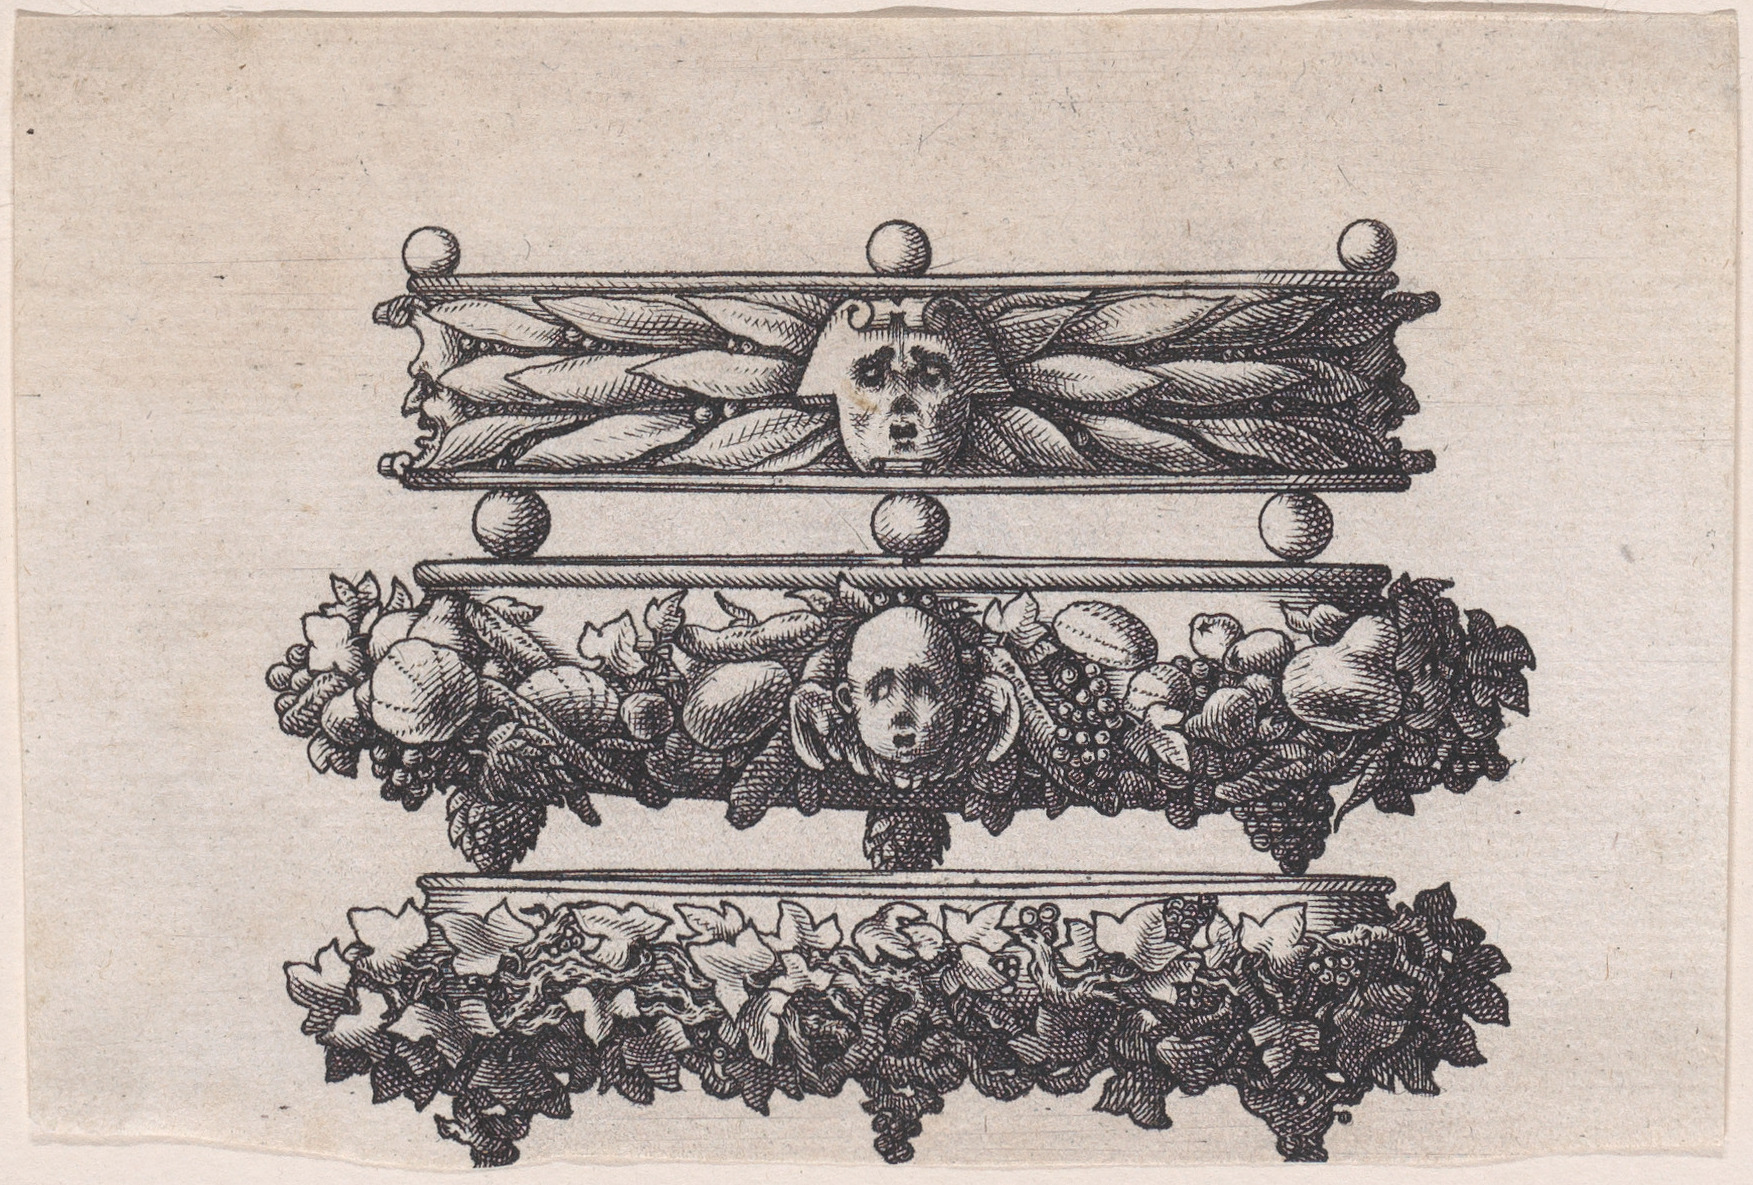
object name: print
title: Three Salvers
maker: rené boyvin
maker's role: artist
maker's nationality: french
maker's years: 1525-1598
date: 1525-1600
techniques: engraving